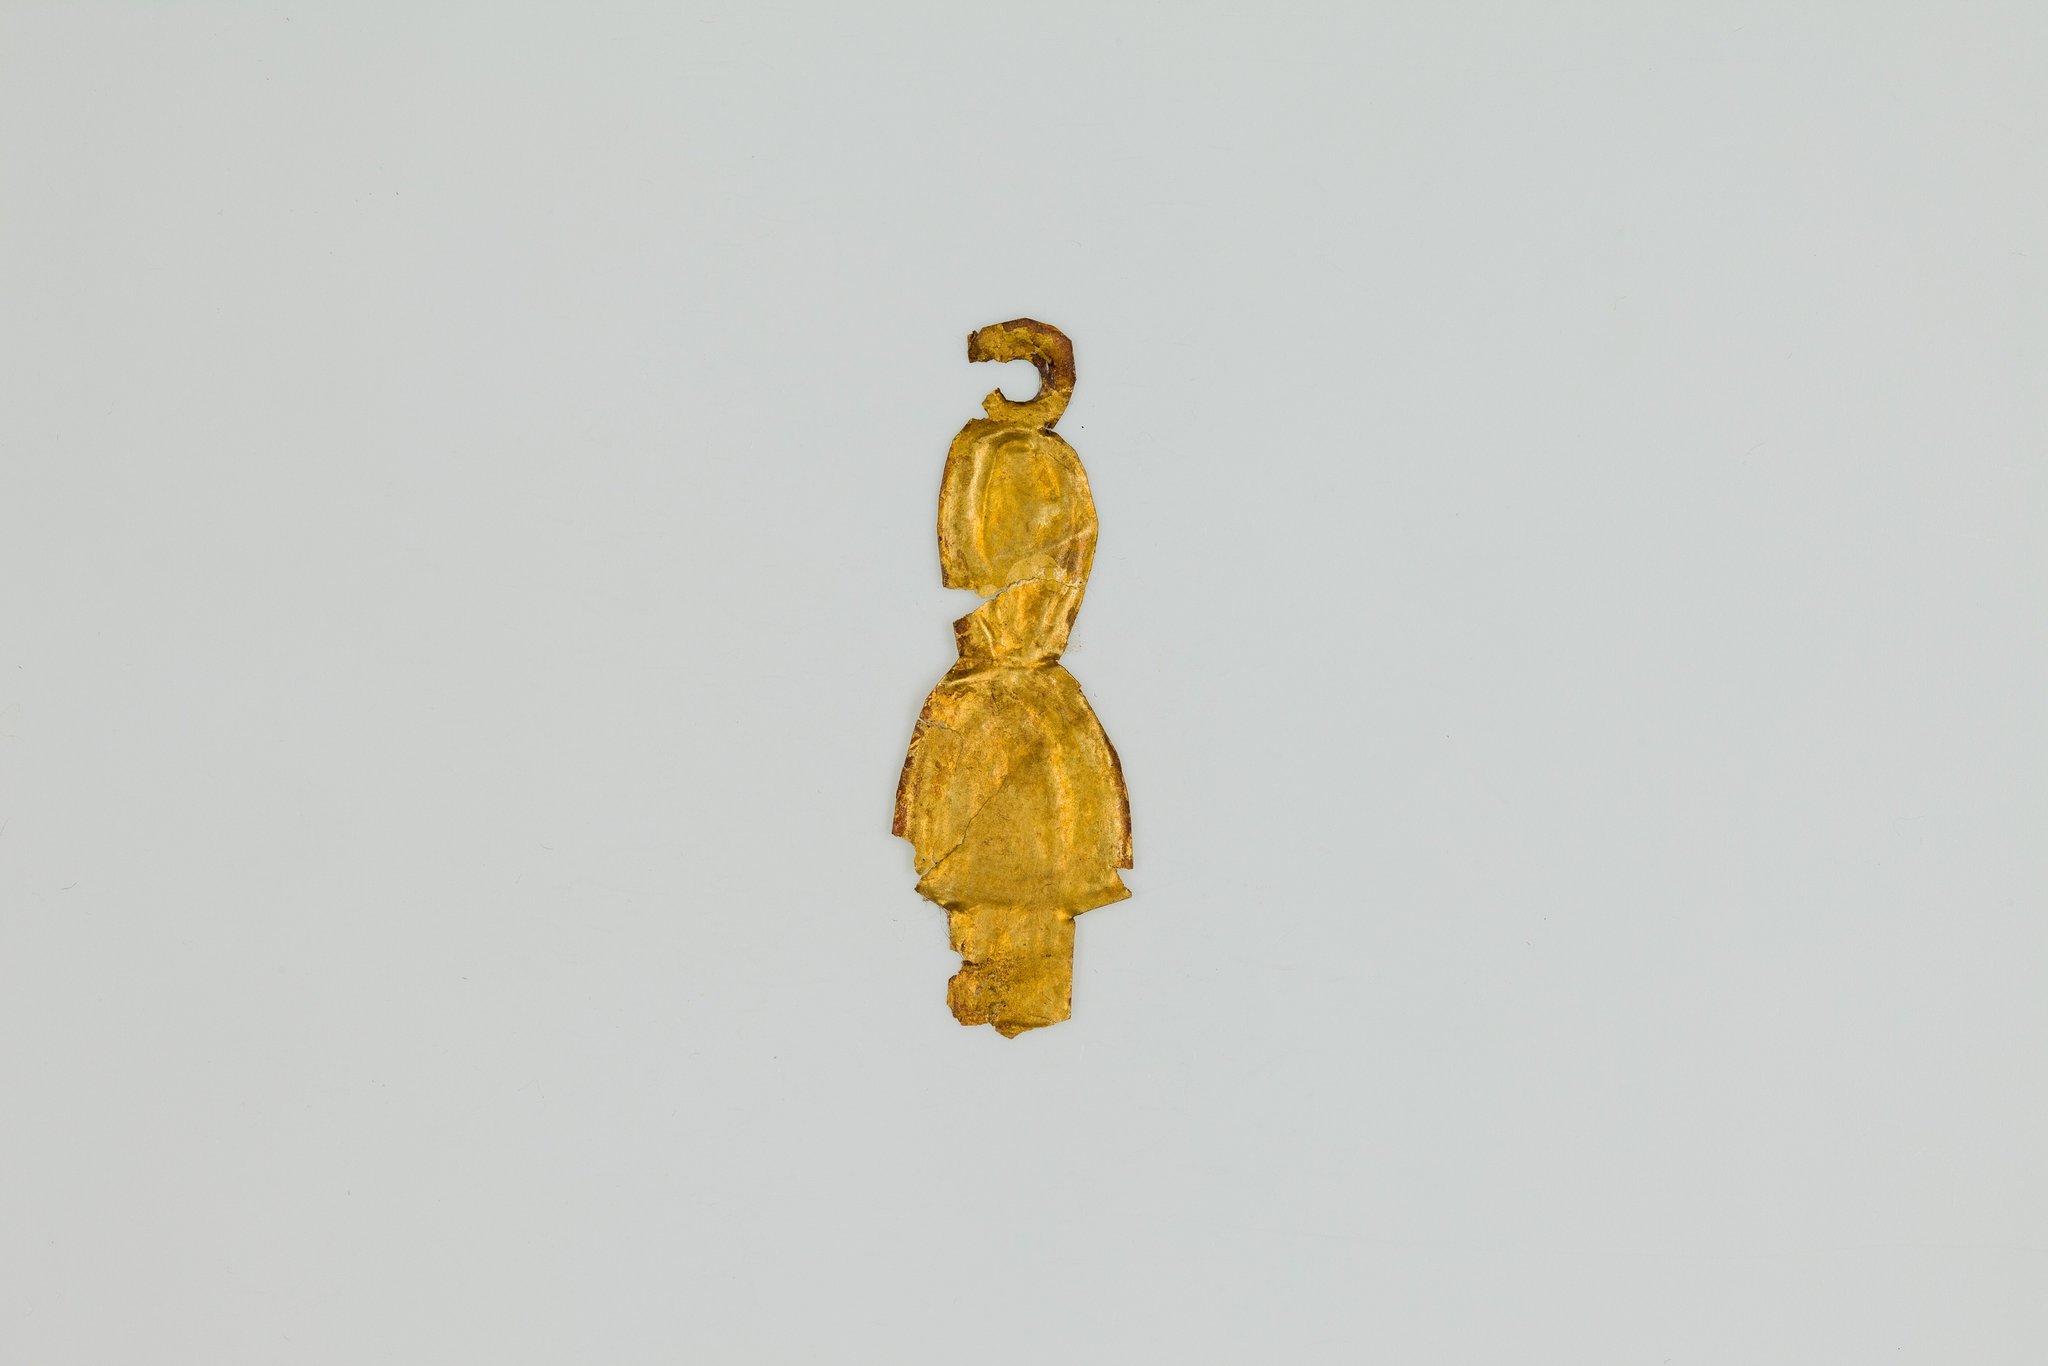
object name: amulet, tit, isi knot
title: Tit (Isis knot) amulet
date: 664-380 BCE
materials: gold